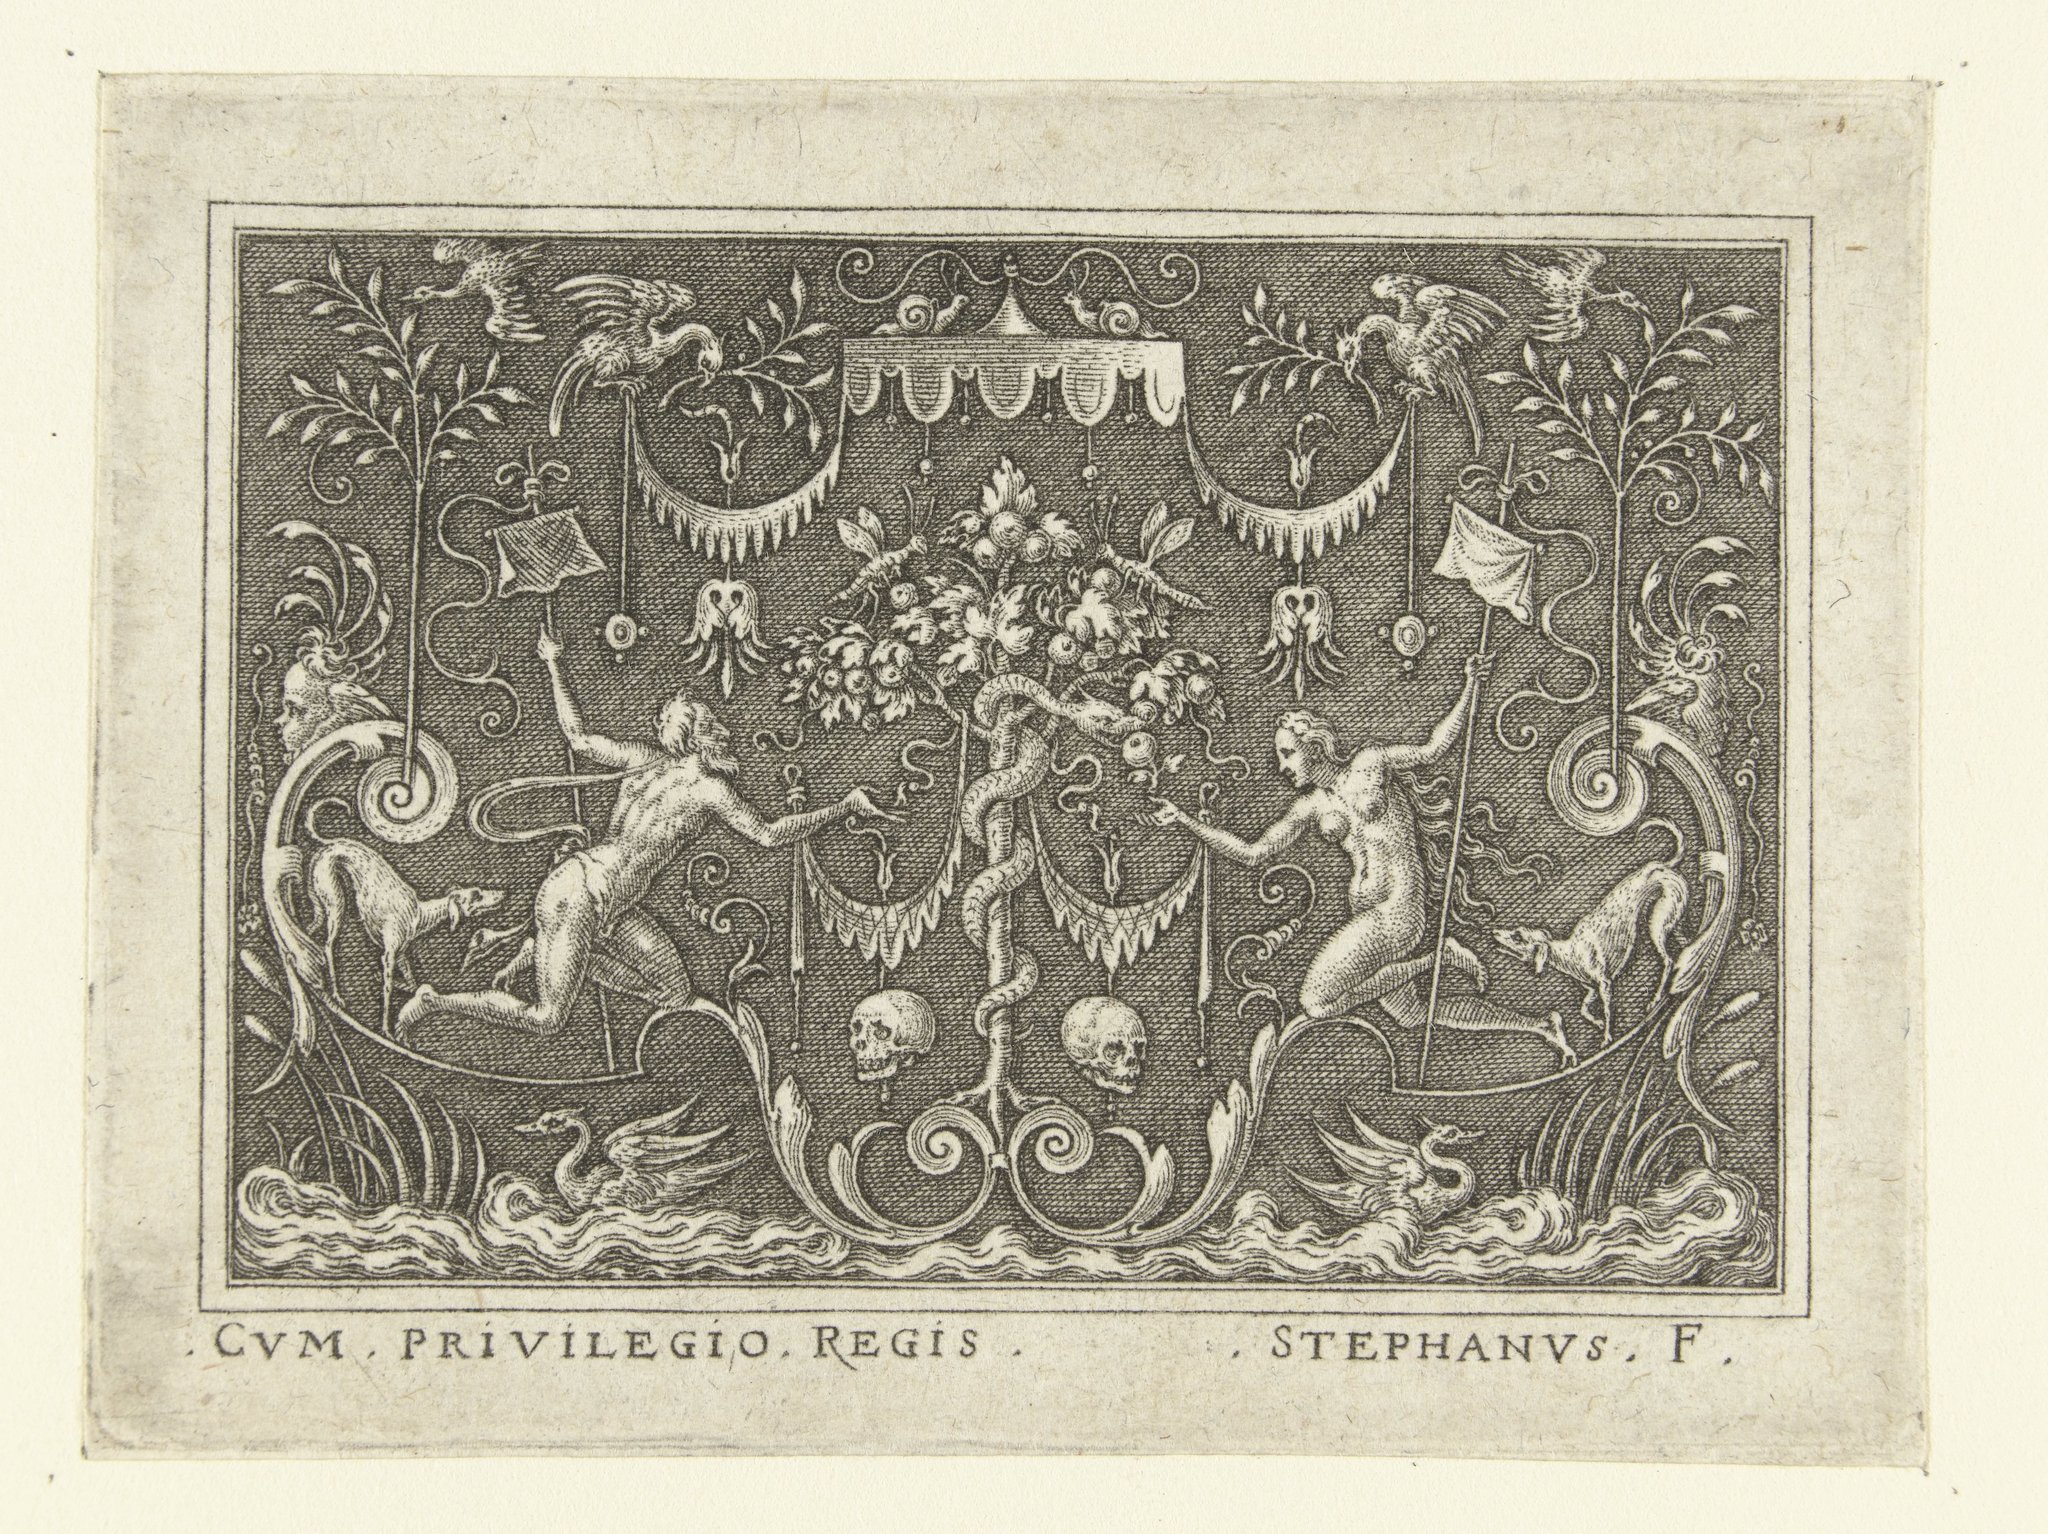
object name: ornament print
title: Vlakdecoraties met scènes uit het Oude Testament in een omlijsting van grotesken (latere versie)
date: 1528-1583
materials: paper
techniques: engraving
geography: france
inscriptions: collector's mark: Lugt 240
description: Zowel Adam als Eva zitten geknield op een voluut, met een stok waaraan een vaandel hangt. Zij reiken naar de appels aan de boom in het midden. Uit serie van 6 bladen.